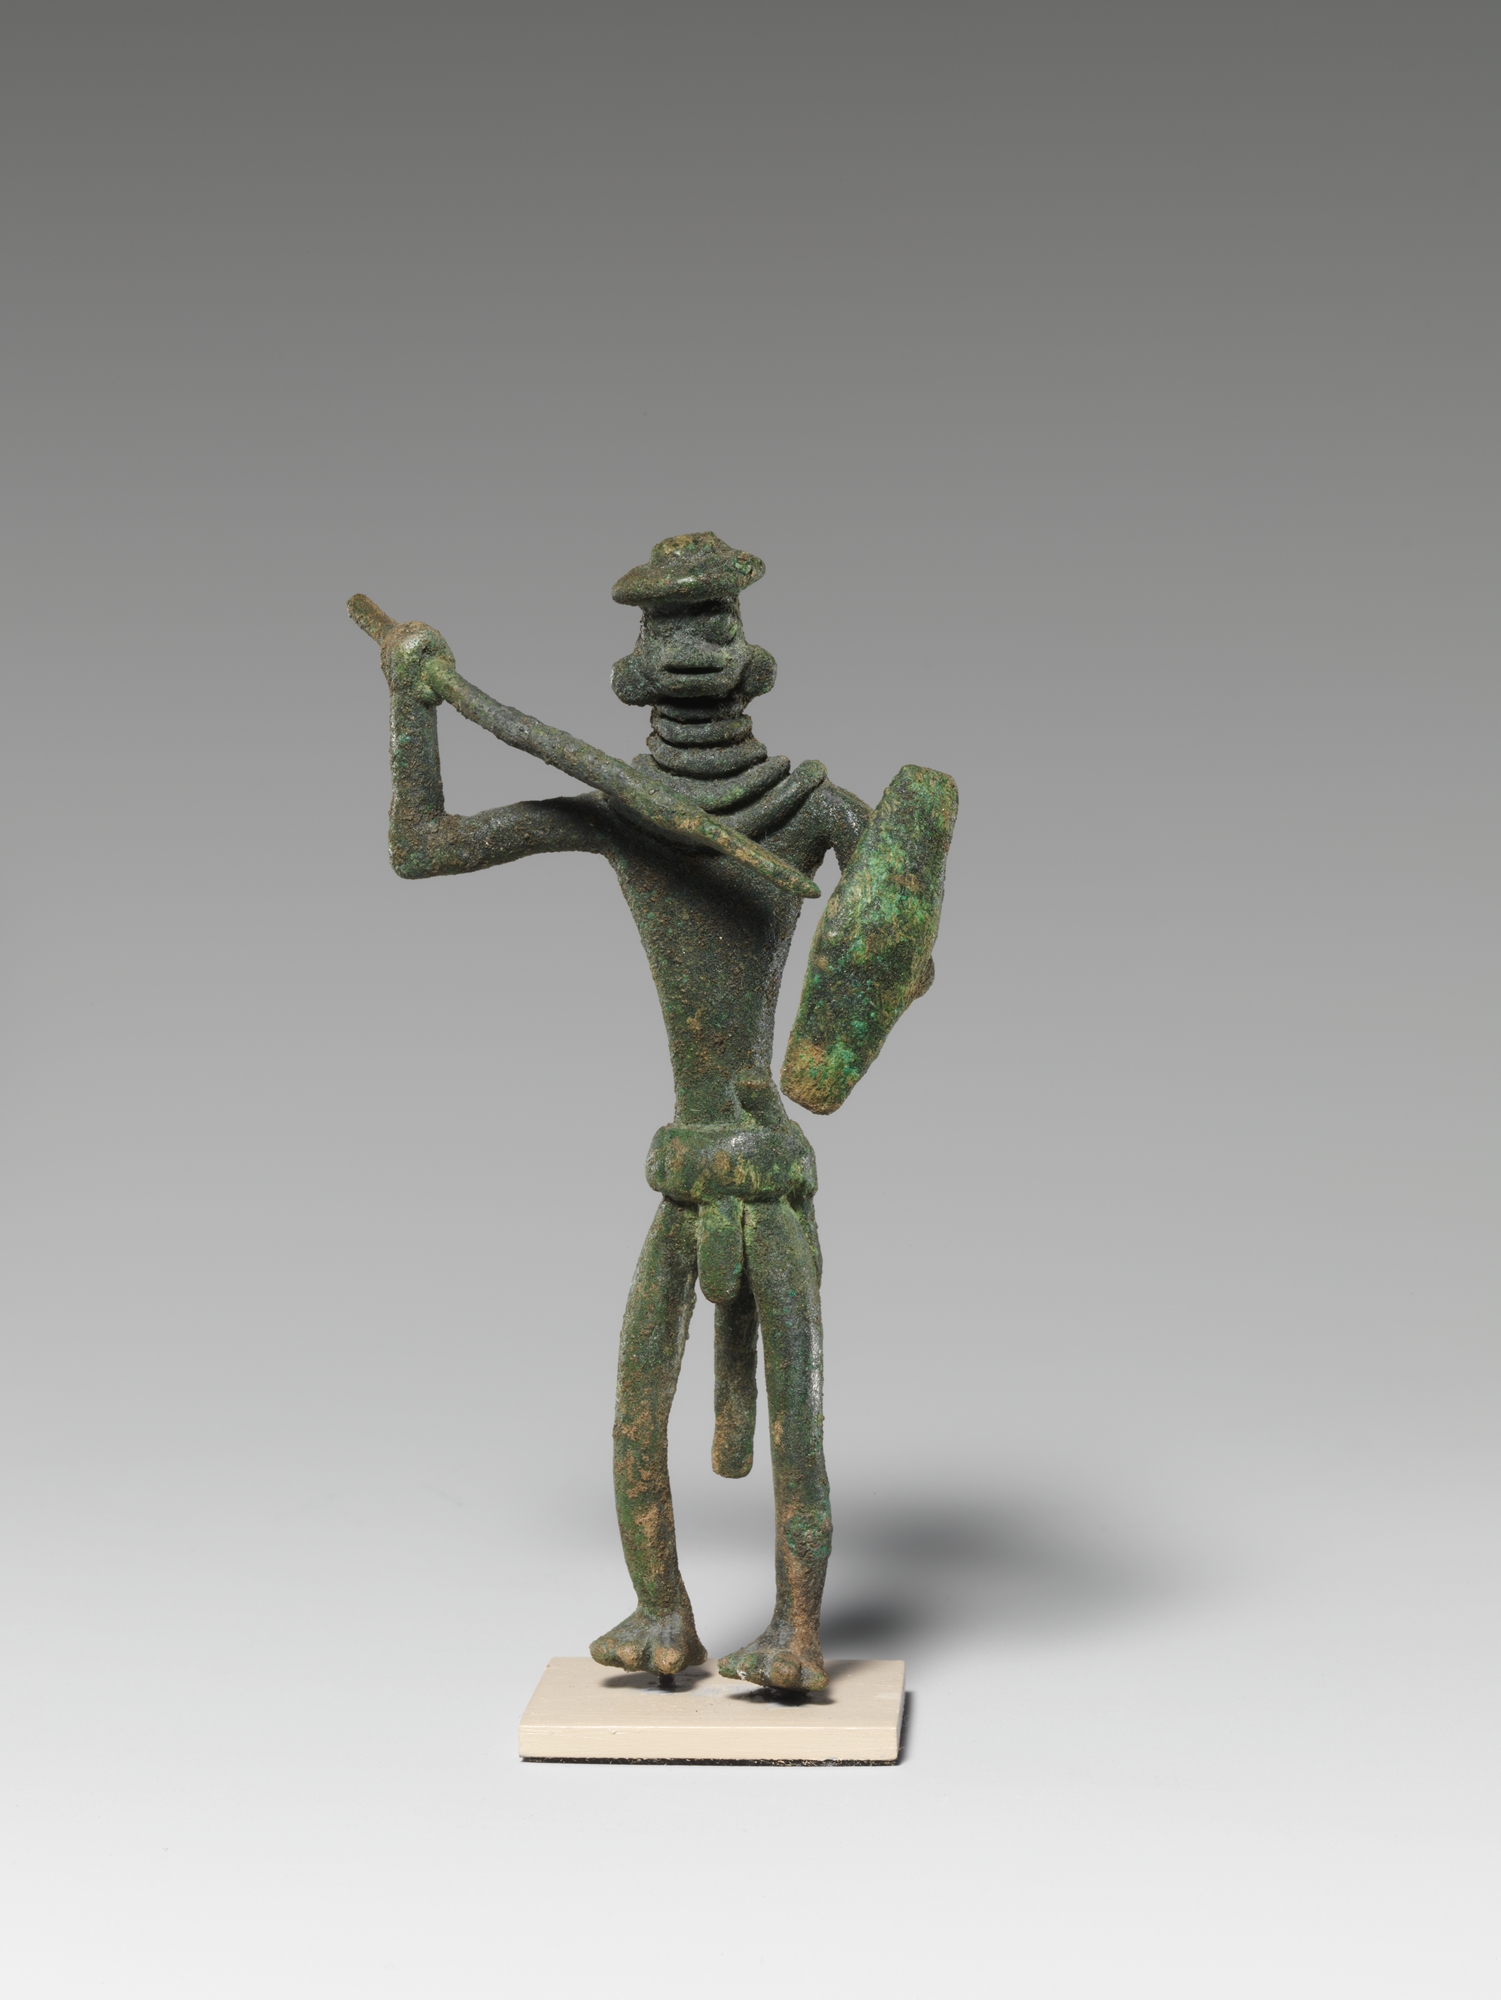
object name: figure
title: Standing Warrior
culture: indonesian, javanese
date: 500 BCE-300 CE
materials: bronze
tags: weapons,men